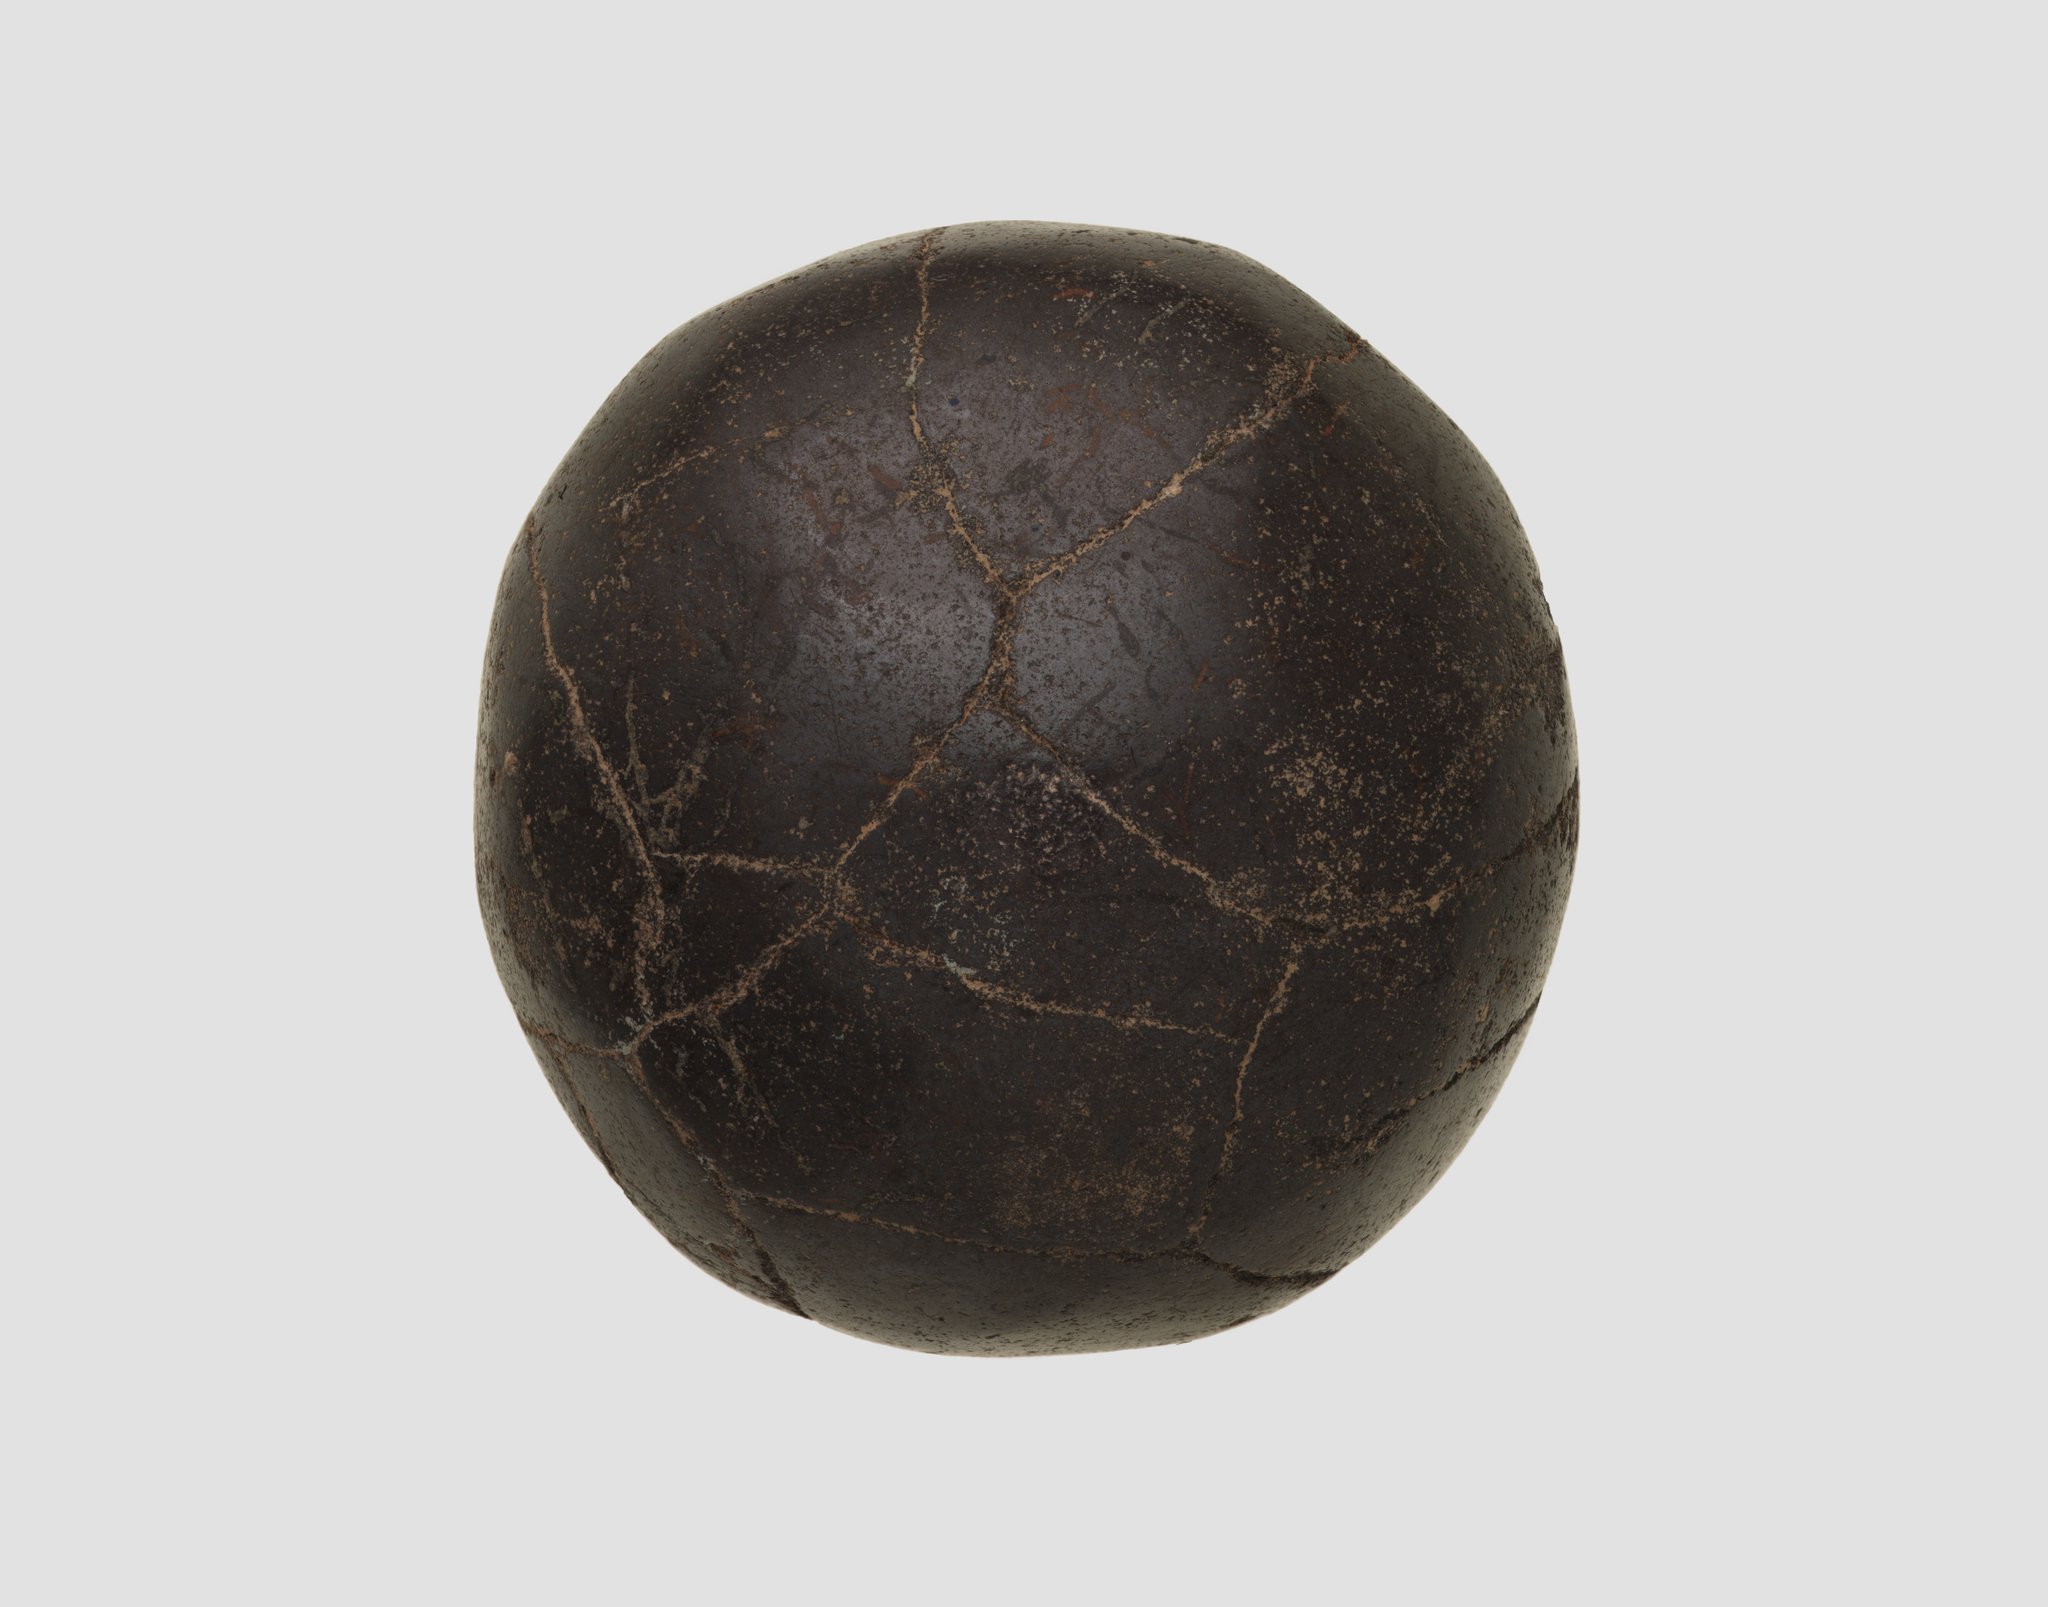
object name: weight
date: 3000-1 BCE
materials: mineral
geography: cyprus or western asia